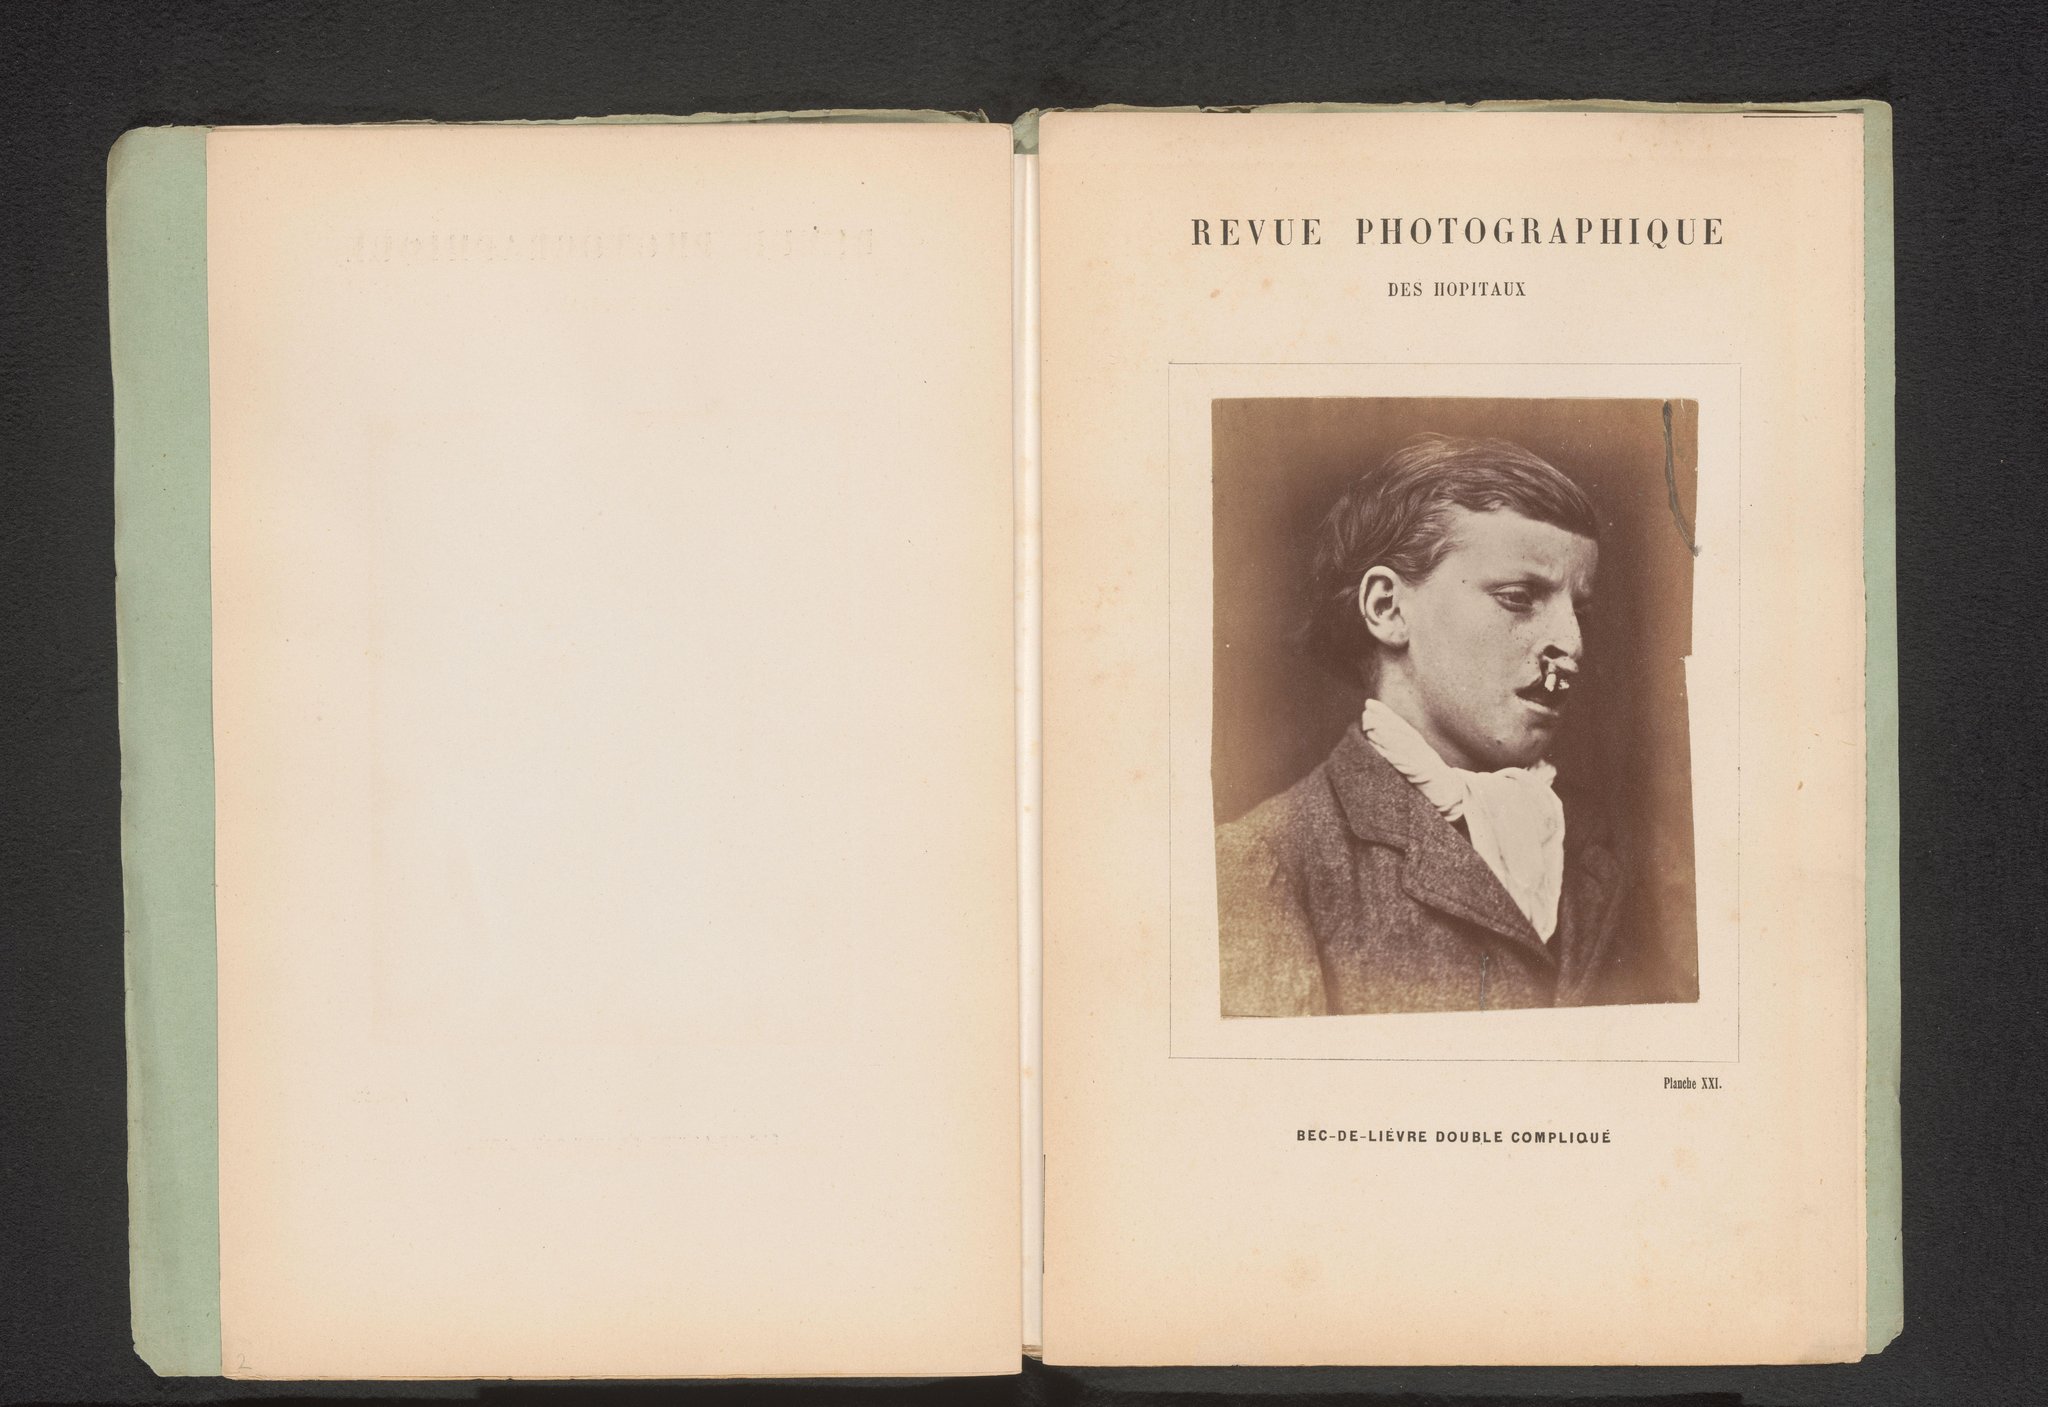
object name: photograph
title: Bec-de-lièvre double compliqué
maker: Anonymous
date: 1865-1870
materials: paper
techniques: albumen print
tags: hare-lip, historical persons, youth, adolescent, medical research, branches of medicine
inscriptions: inscription: ‘Revue photographique/ des hopitaux/ Planche XXI.’